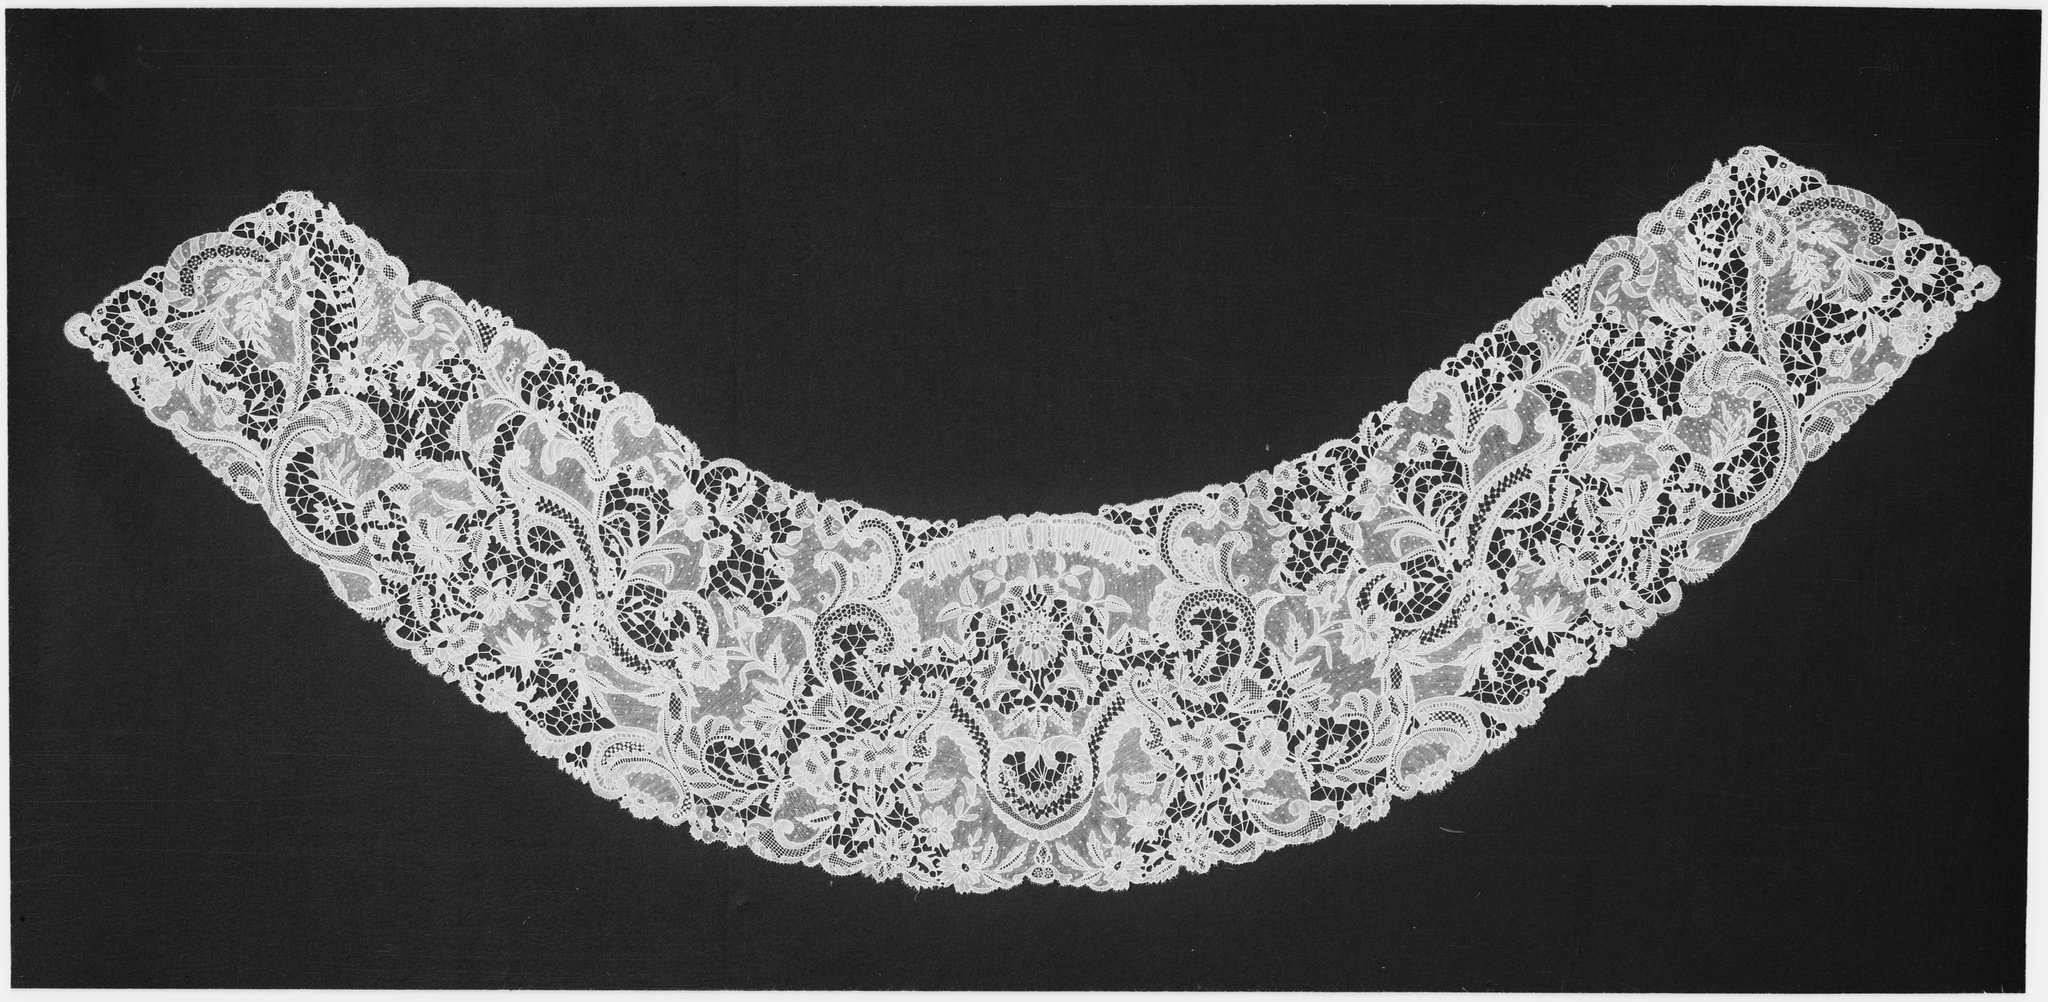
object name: collar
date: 1850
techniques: lace